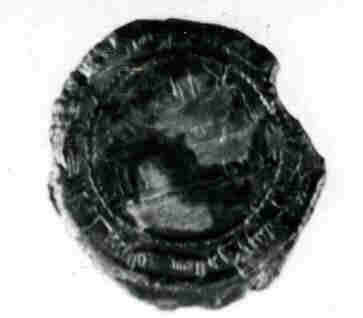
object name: coin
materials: copper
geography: iran